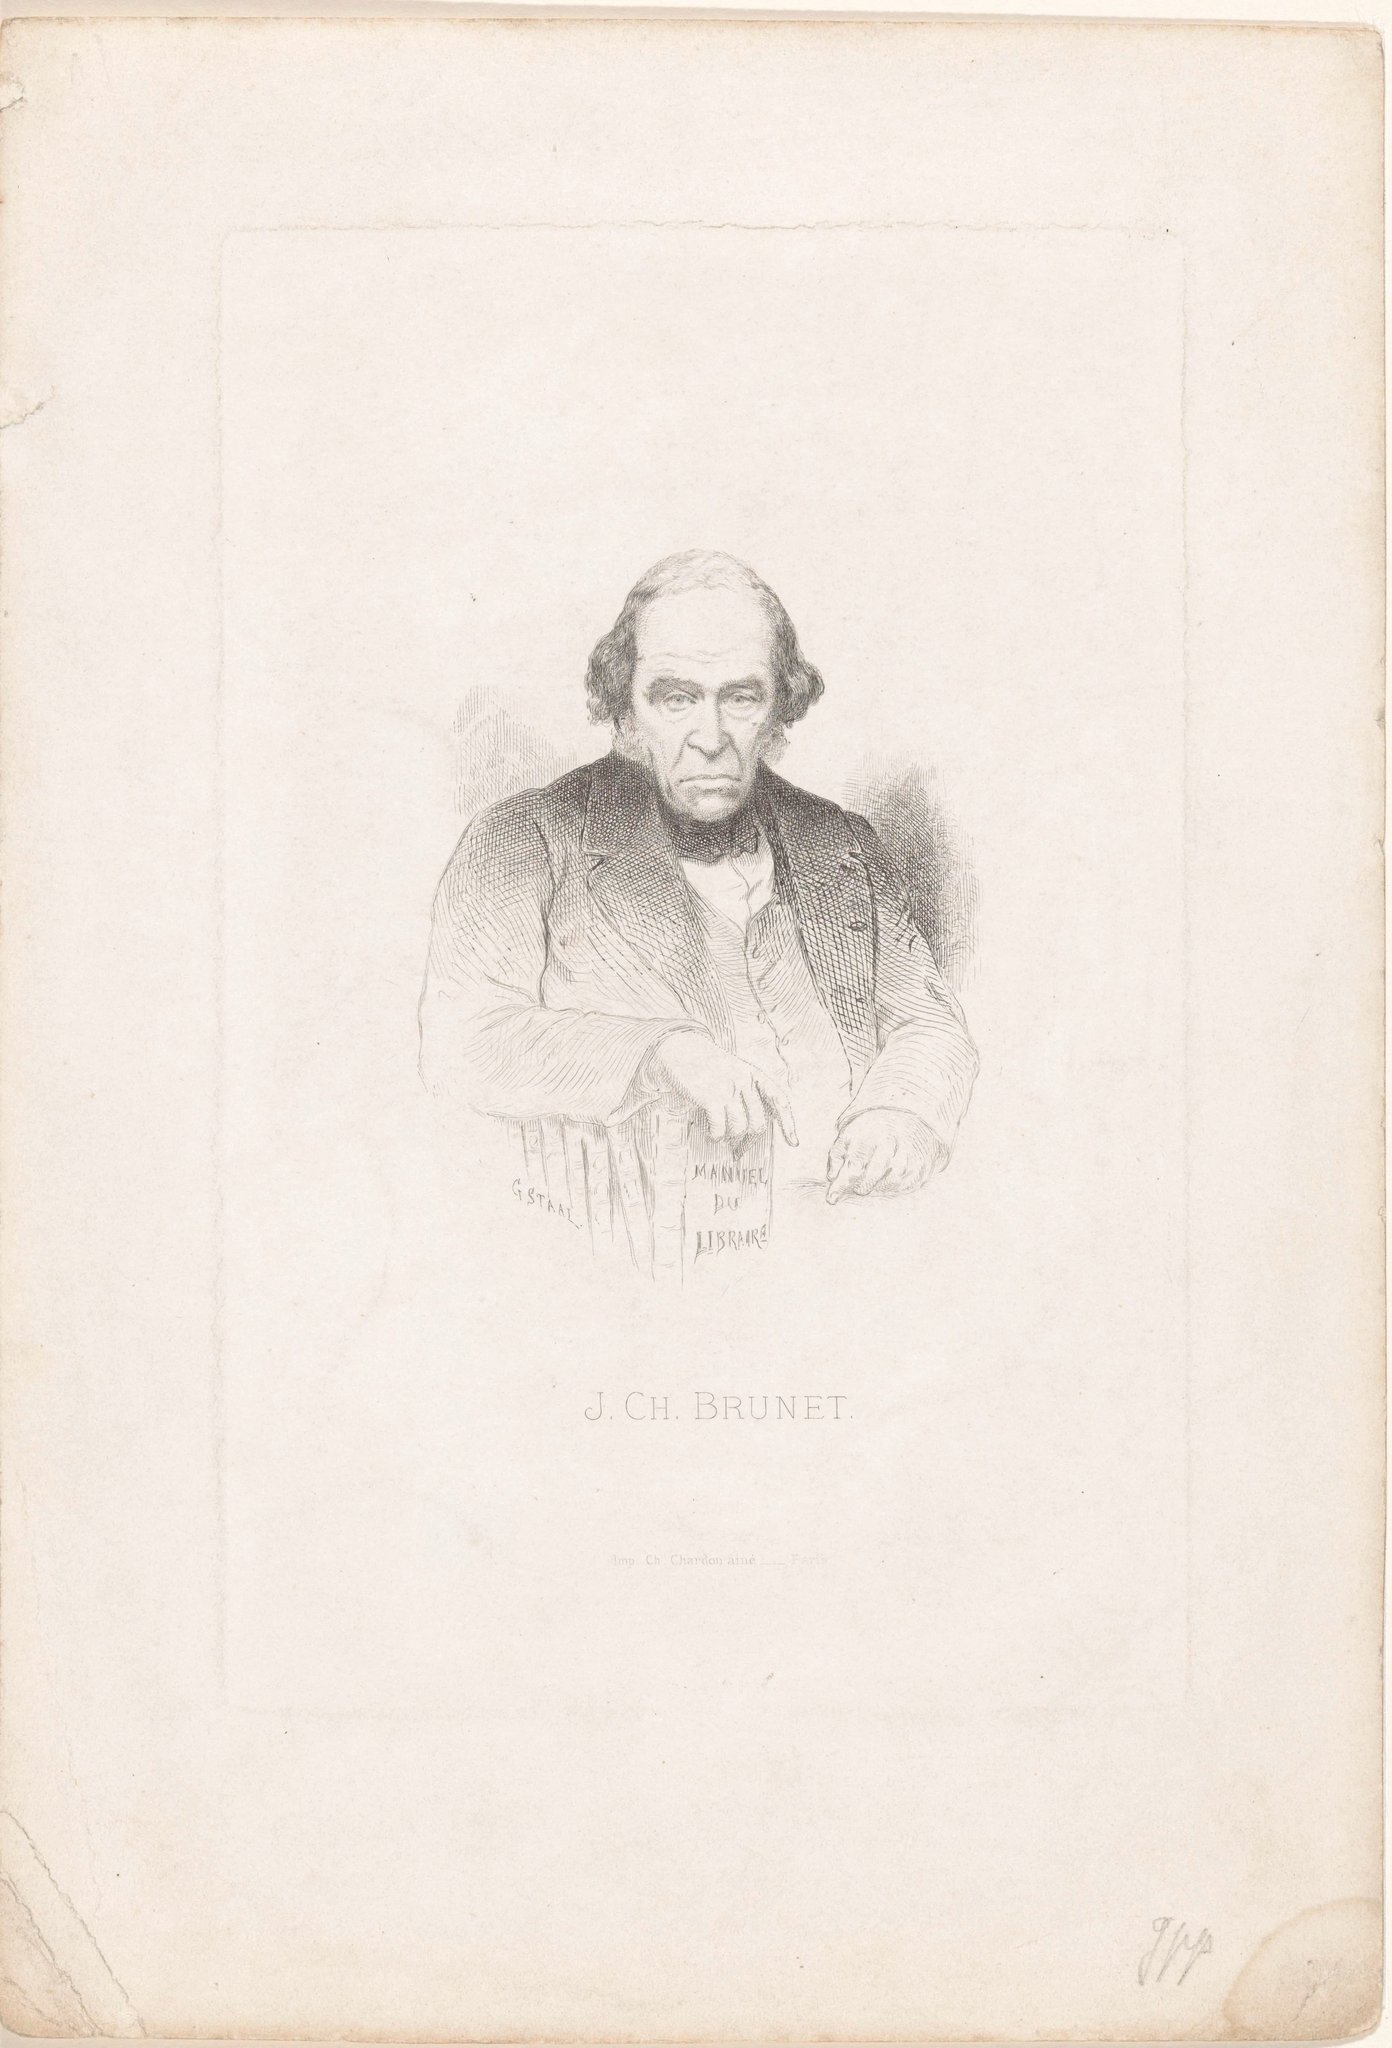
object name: illustration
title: J. Ch. Brunet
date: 1805-1868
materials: paper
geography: paris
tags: paris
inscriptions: collector's mark: Lugt 4779, collector's mark: Lugt 2228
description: Met zijn rechterarm leunt de geportretteerde op de zeven delen van zijn bekendste werk: 'Manuel du libraire et de l'amateur de livres'.